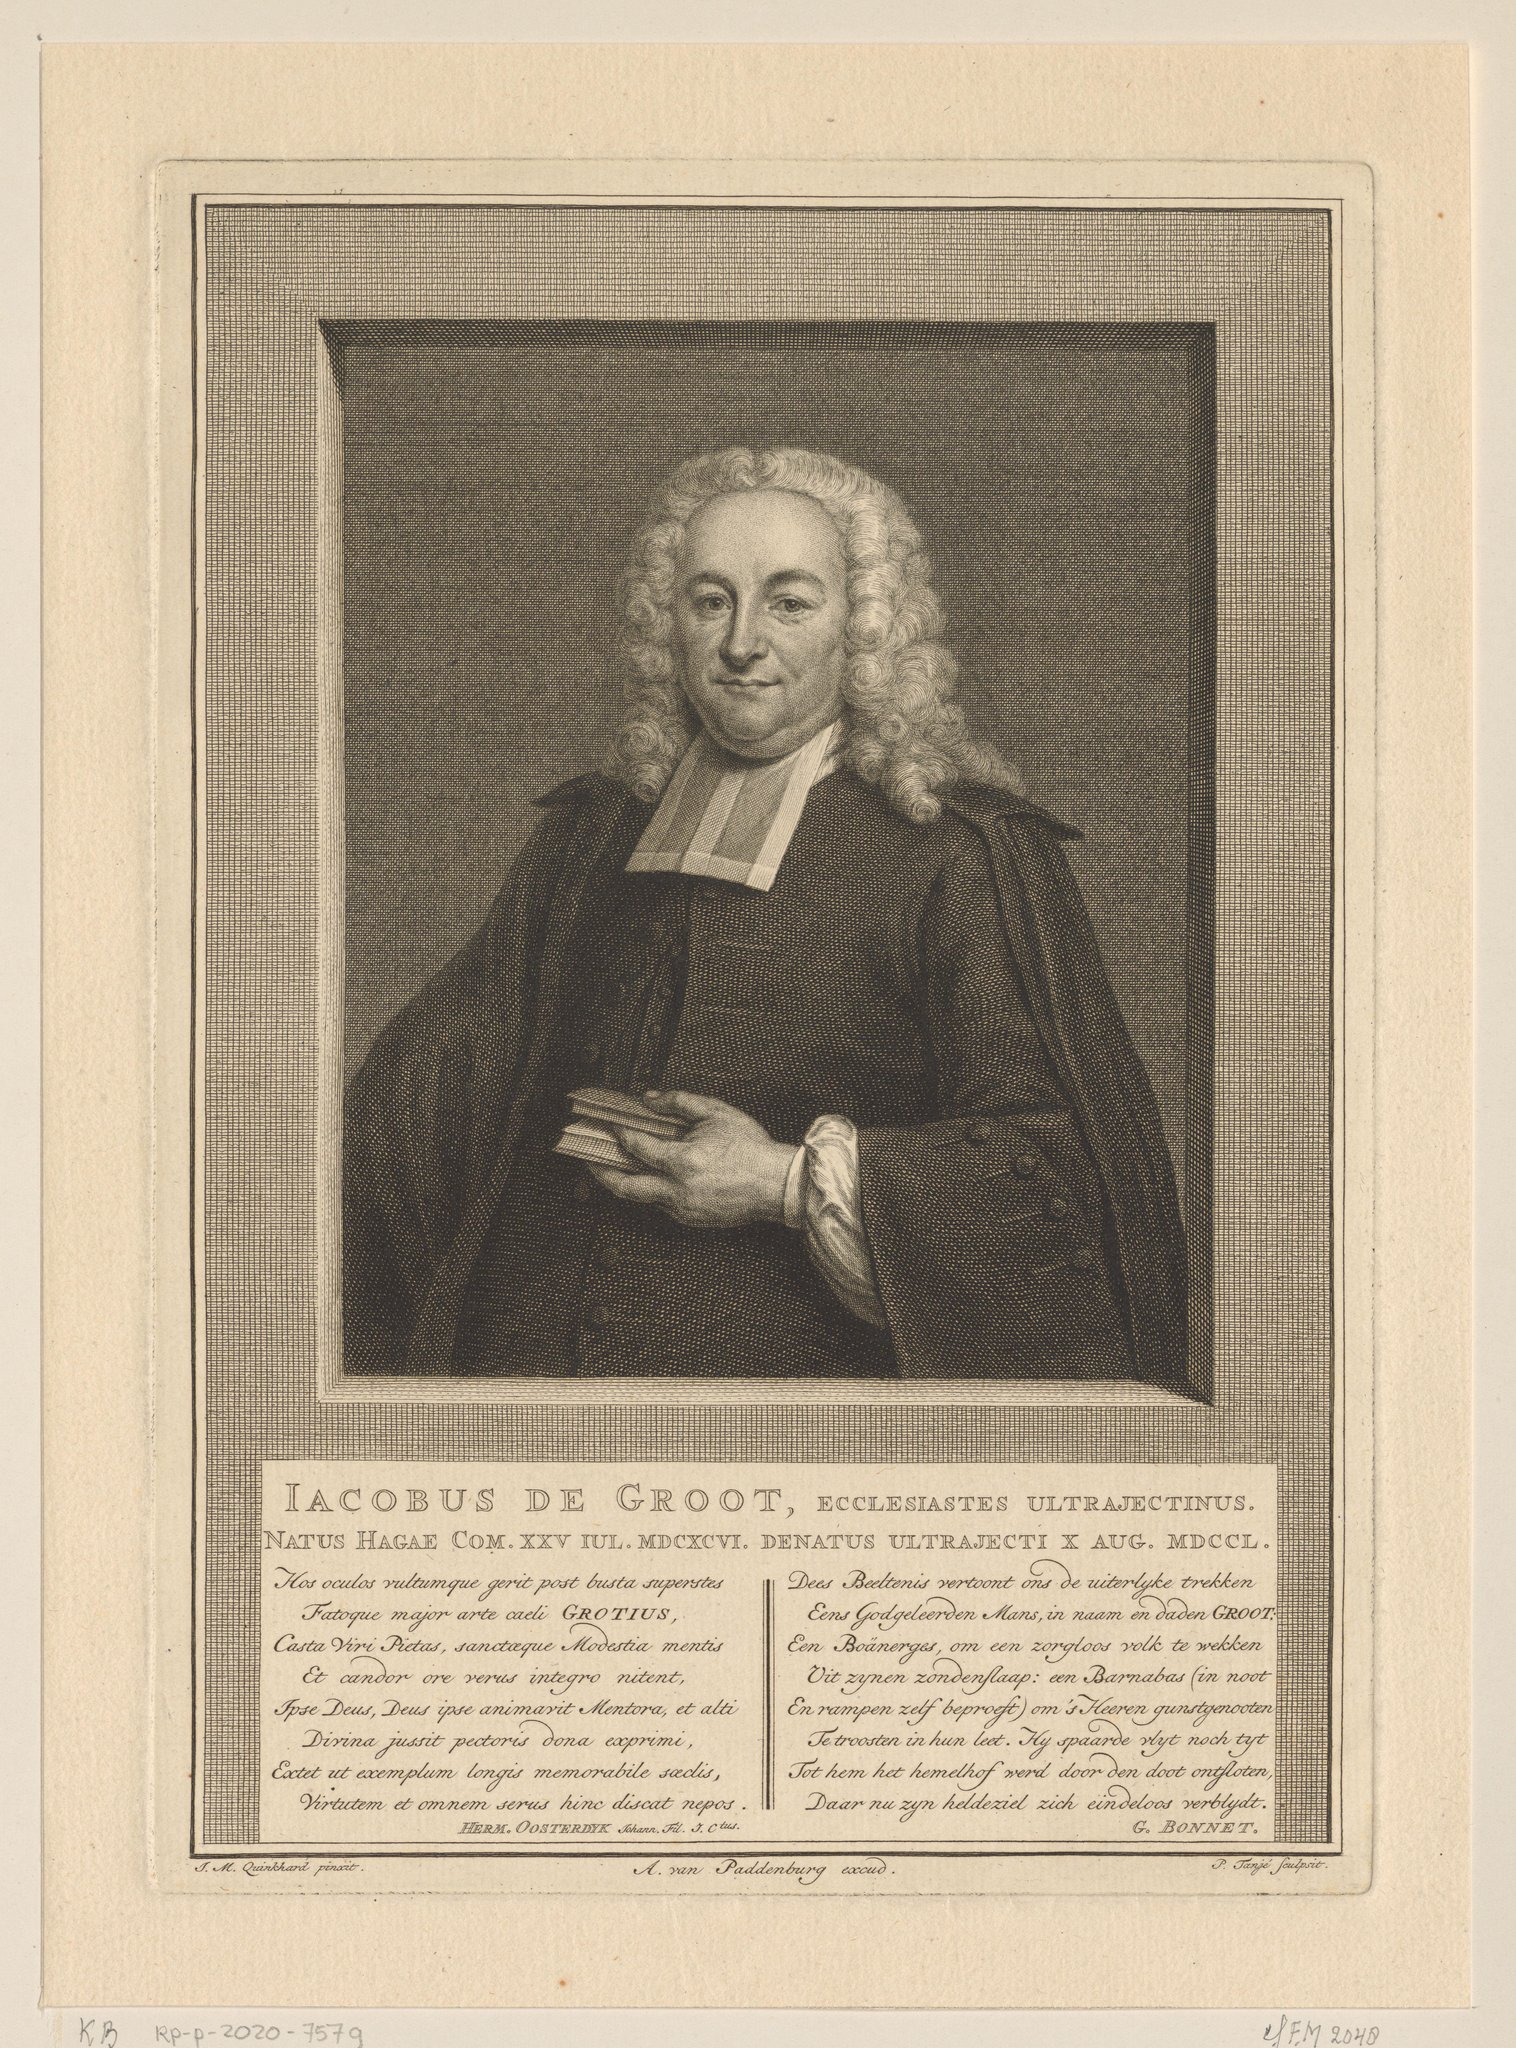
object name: print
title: Portret van Jacob de Groot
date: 1750-1790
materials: paper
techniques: engraving, etching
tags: utrecht, theologian, historical persons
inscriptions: collector's mark: Lugt 240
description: Tekst in het Latijn en het Nederlands in de ondermarge.